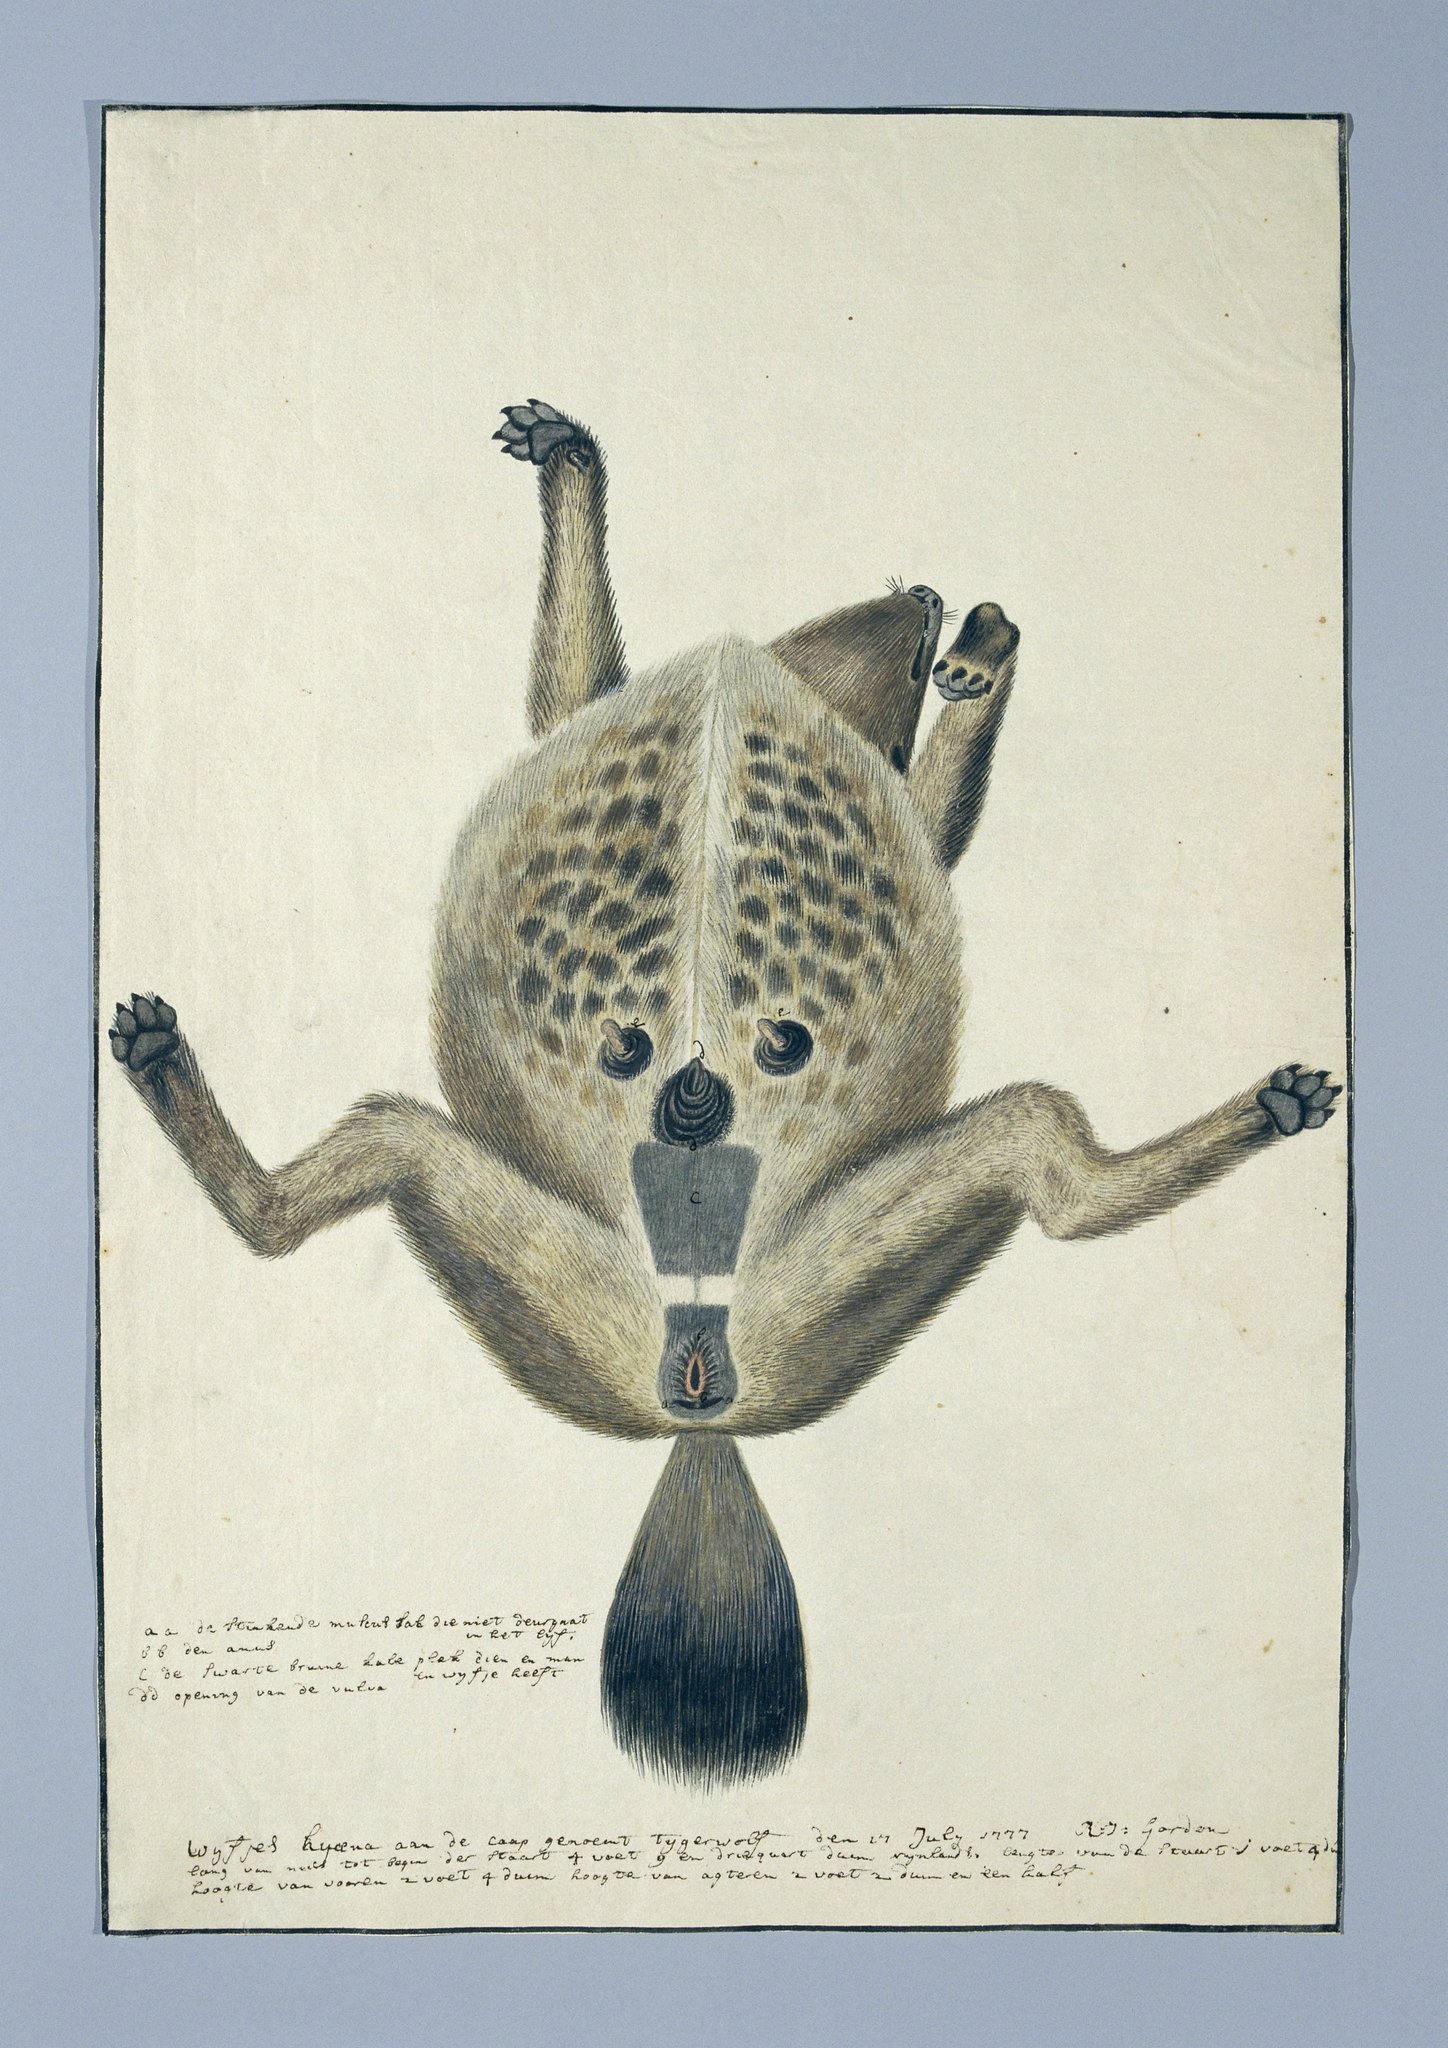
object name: album leaf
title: Crocuta crocuta (Spotted hyena)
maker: robert jacob gordon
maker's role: draughtsman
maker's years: 1743-1795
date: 1777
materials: ink, paper, watercolor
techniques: brush, pen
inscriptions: inscription: ‘links: a-d (onder elkaar en gevolgd door beschrijvingen); onderaan: Wyfjes hy[a]ena aan de caap genoemt tygerwolf’, signature and date: ‘...den 17 July 1777 R:J: Gordon’